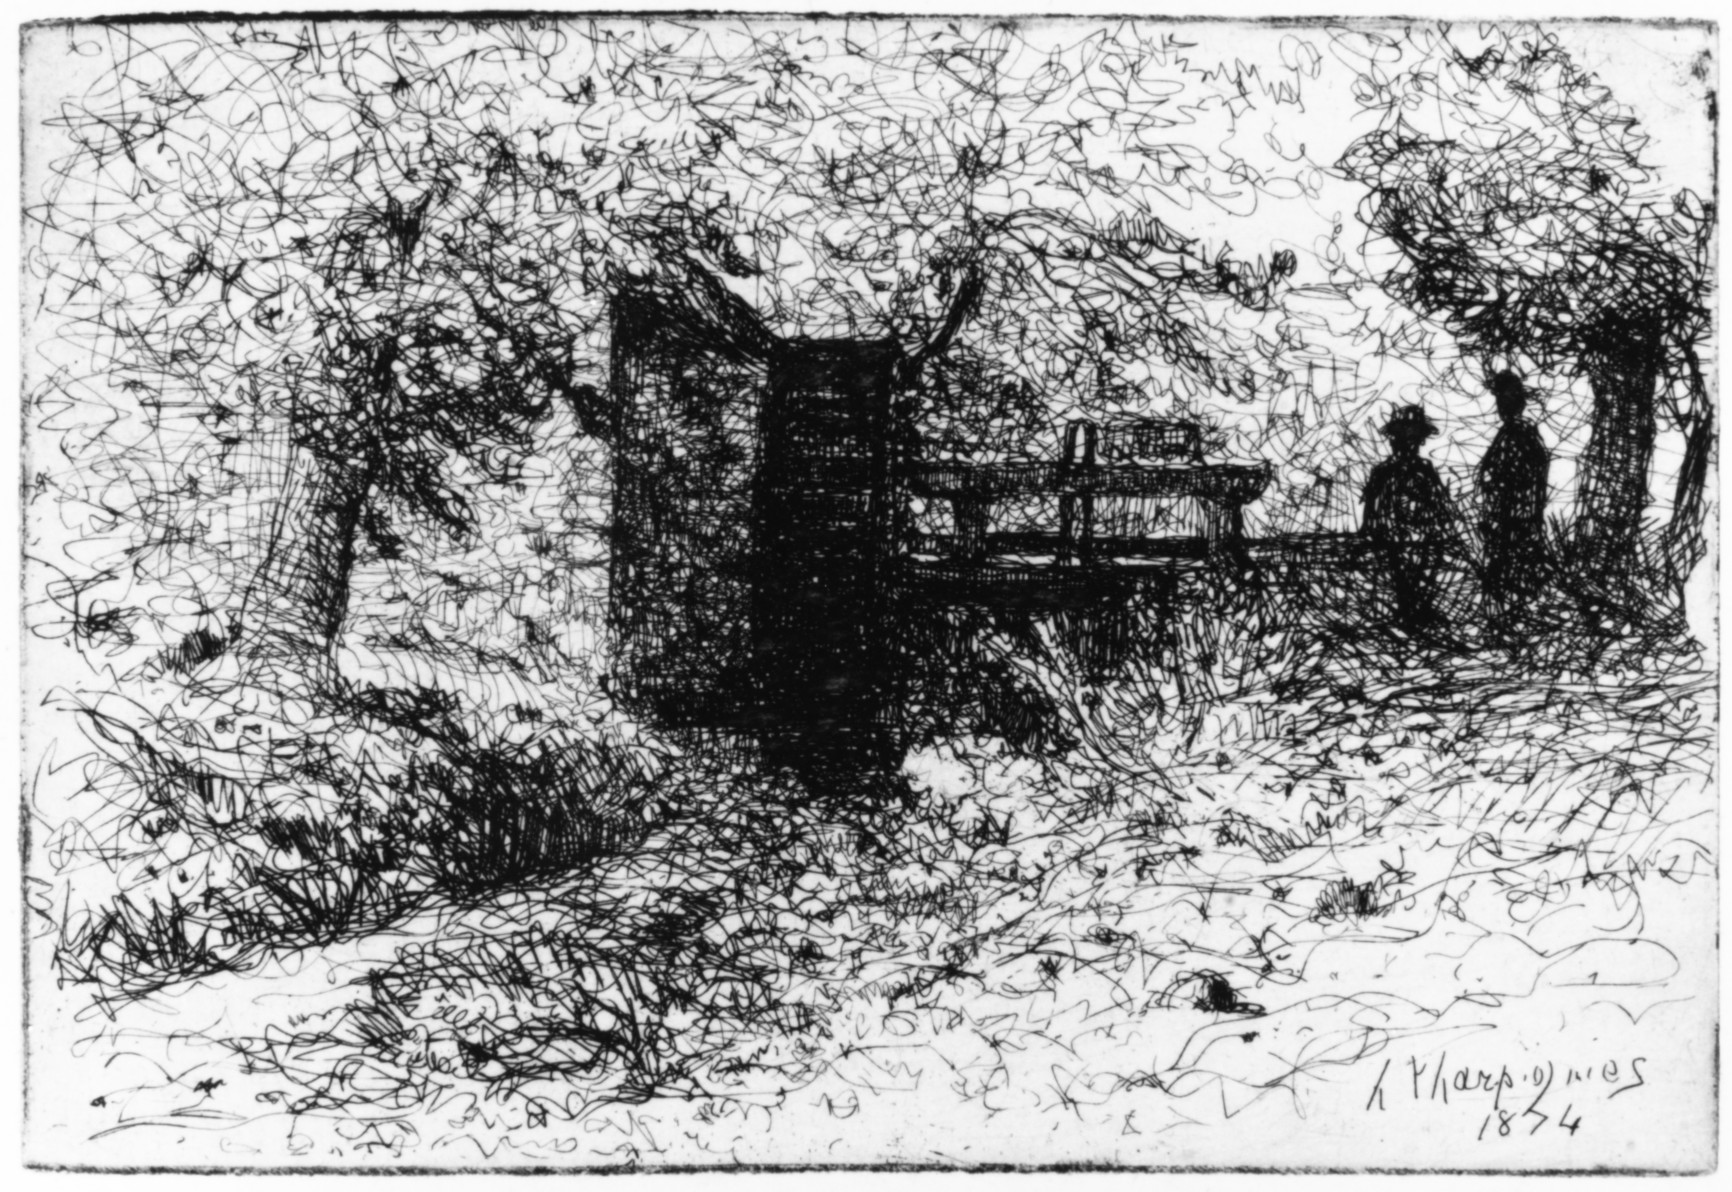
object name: print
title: Two Figures by a Small Watergate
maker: henri-joseph harpignies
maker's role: artist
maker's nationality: french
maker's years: 1819-1916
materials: paper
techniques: etching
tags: human figures,gates